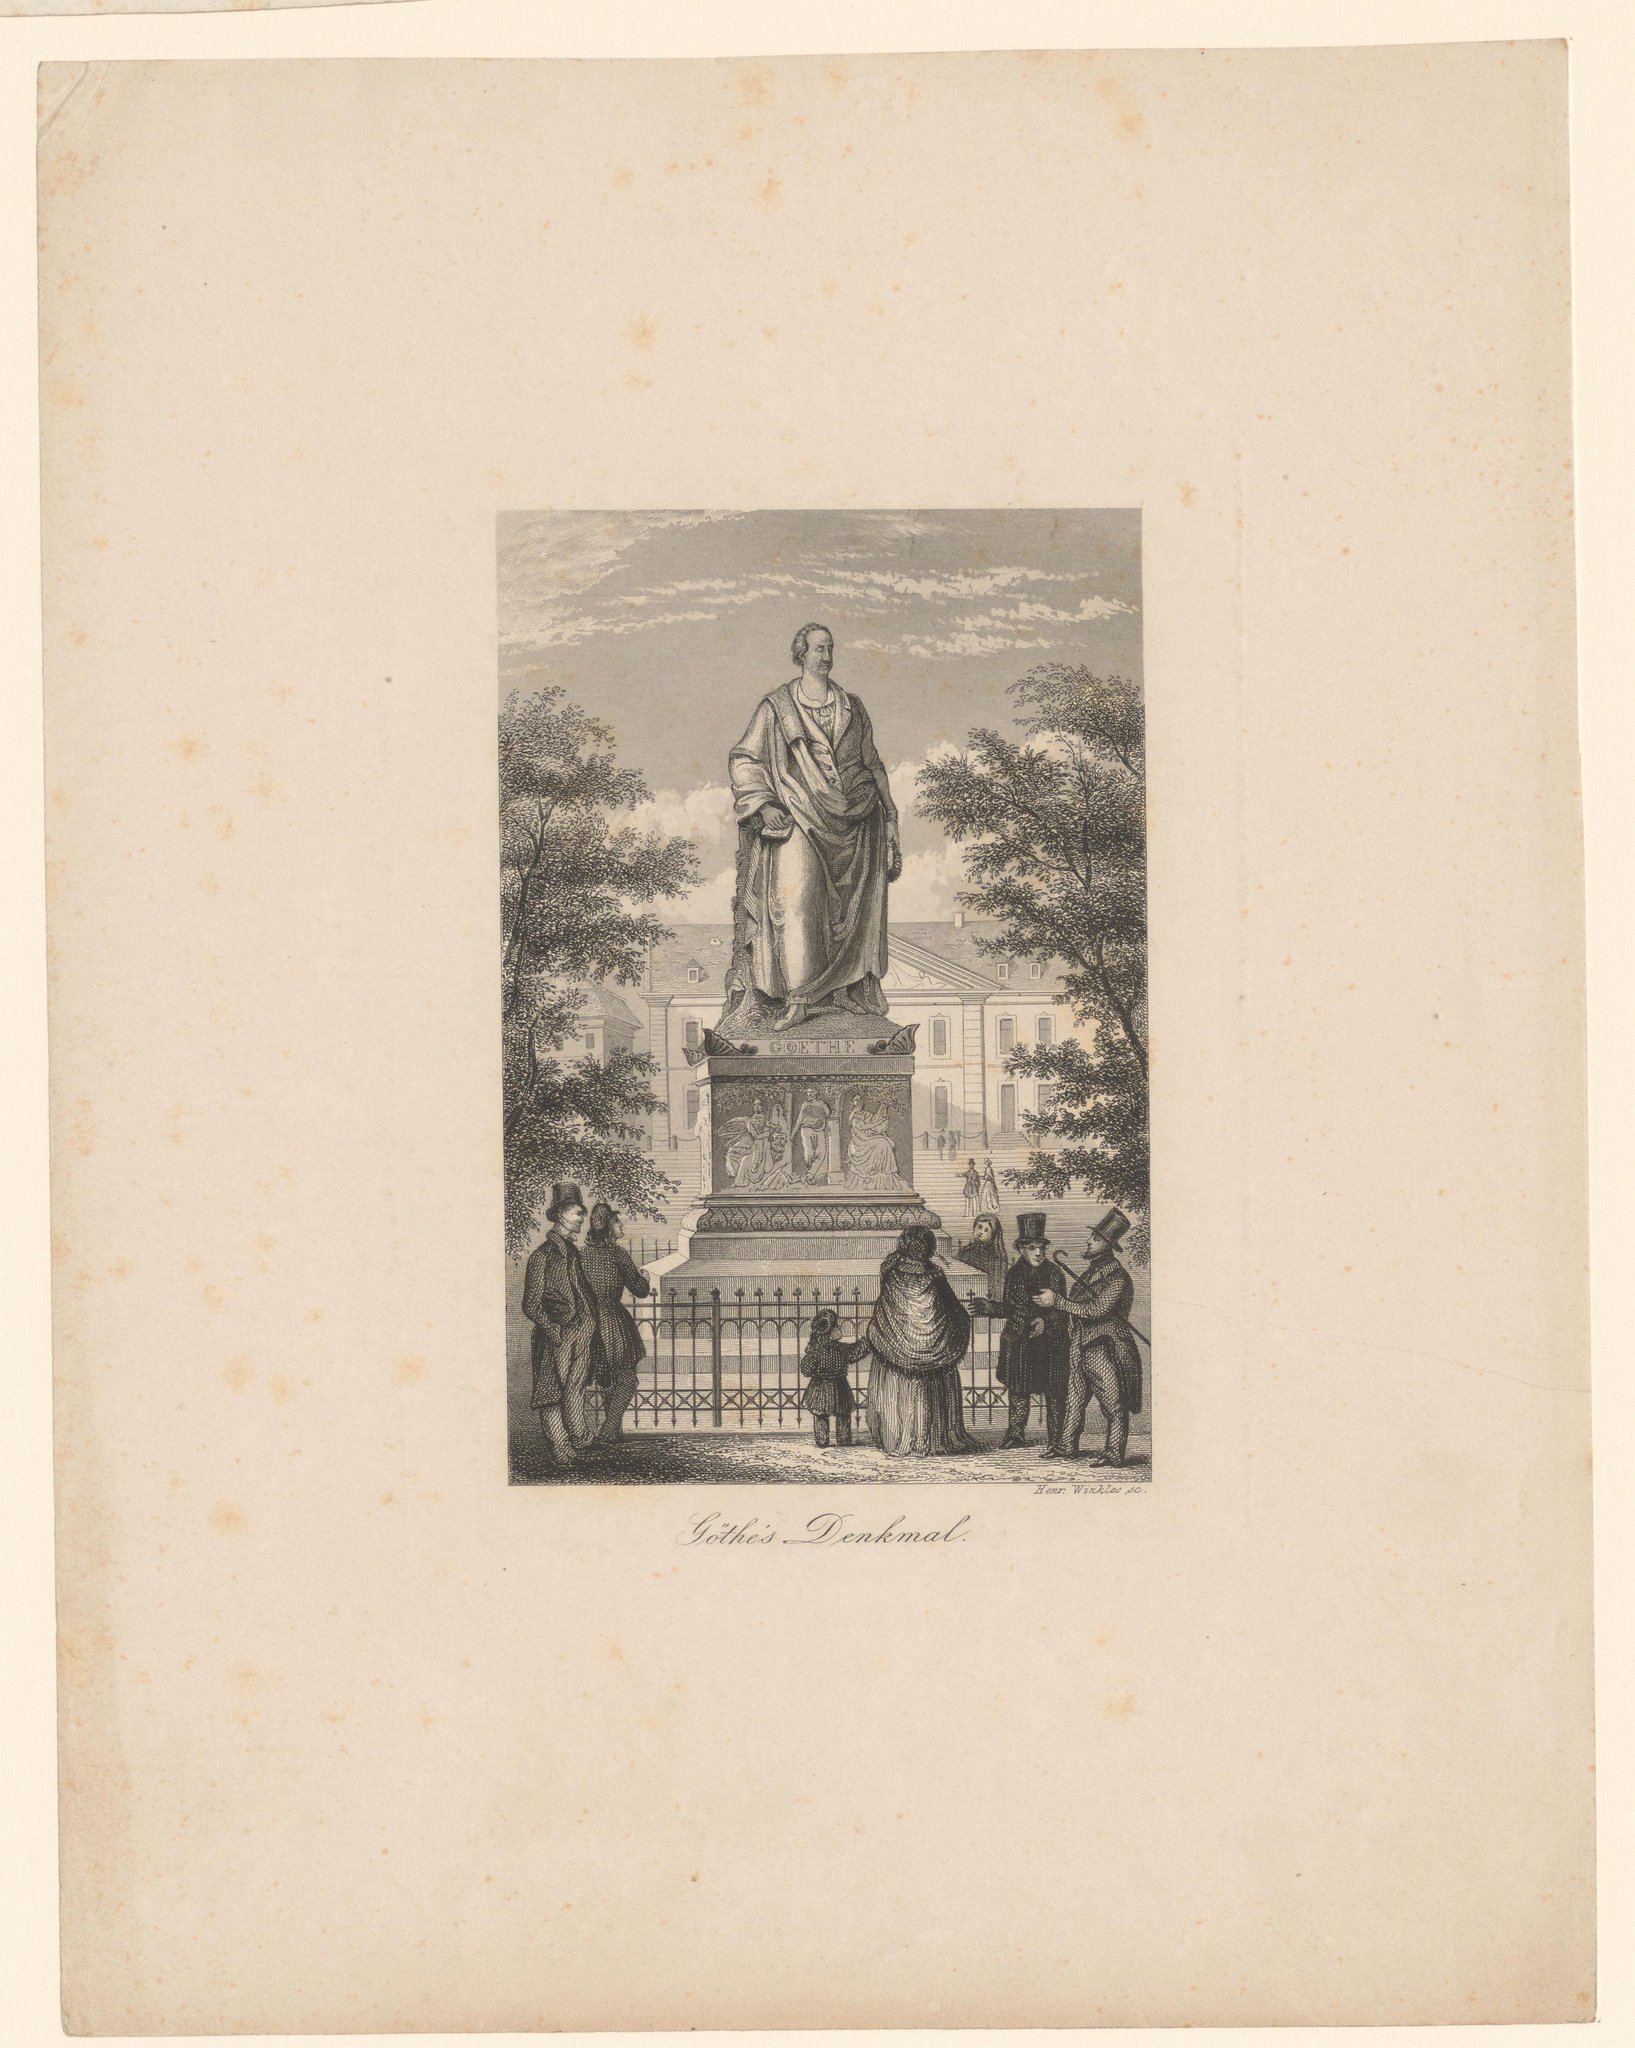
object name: print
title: Göthe's Denkmal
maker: henry winkles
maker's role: painter, print maker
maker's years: 1801-1860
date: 1844-1860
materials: paper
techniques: etching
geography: germany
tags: draughtsman, johann wolfgang von goethe, historical persons, monument, statue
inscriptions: collector's mark: Lugt 2228